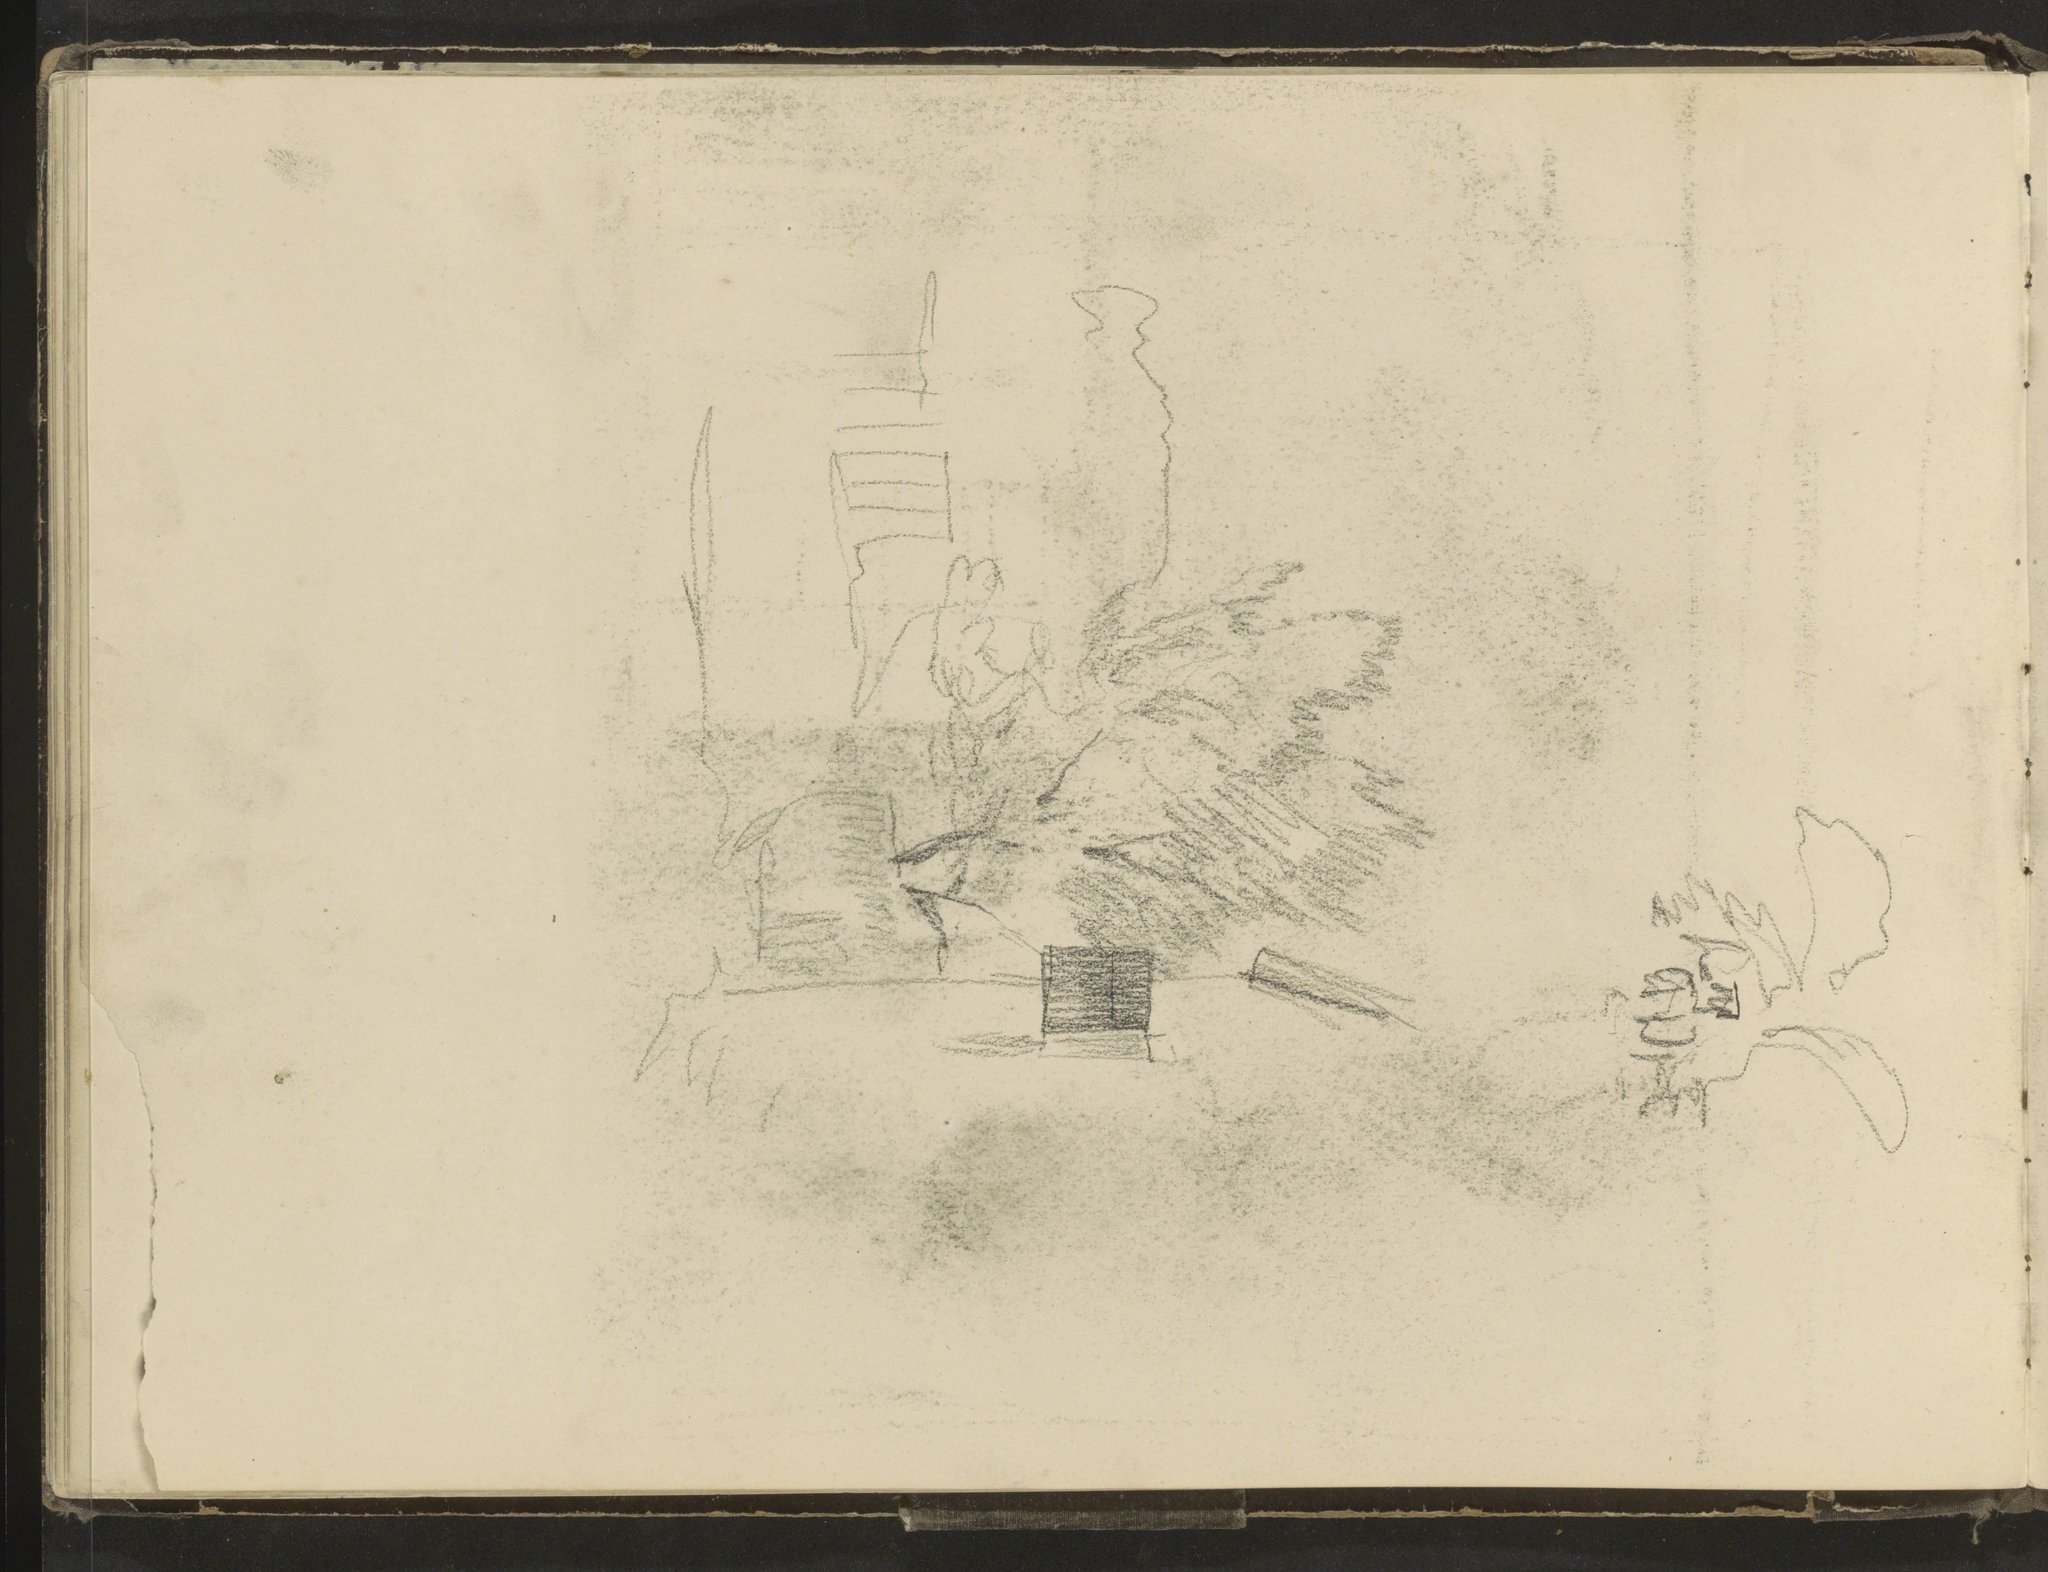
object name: sketchbook leaf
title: Bomen naast een plattelandswoning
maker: albert neuhuys (1844-1914)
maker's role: draughtsman, painter, print maker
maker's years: 1844-1914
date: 1854-1914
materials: charcoal, paper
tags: trees, rural housing, e.g. country-house, villa, cottage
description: Blad 20 verso uit een schetsboek met 43 bladen.